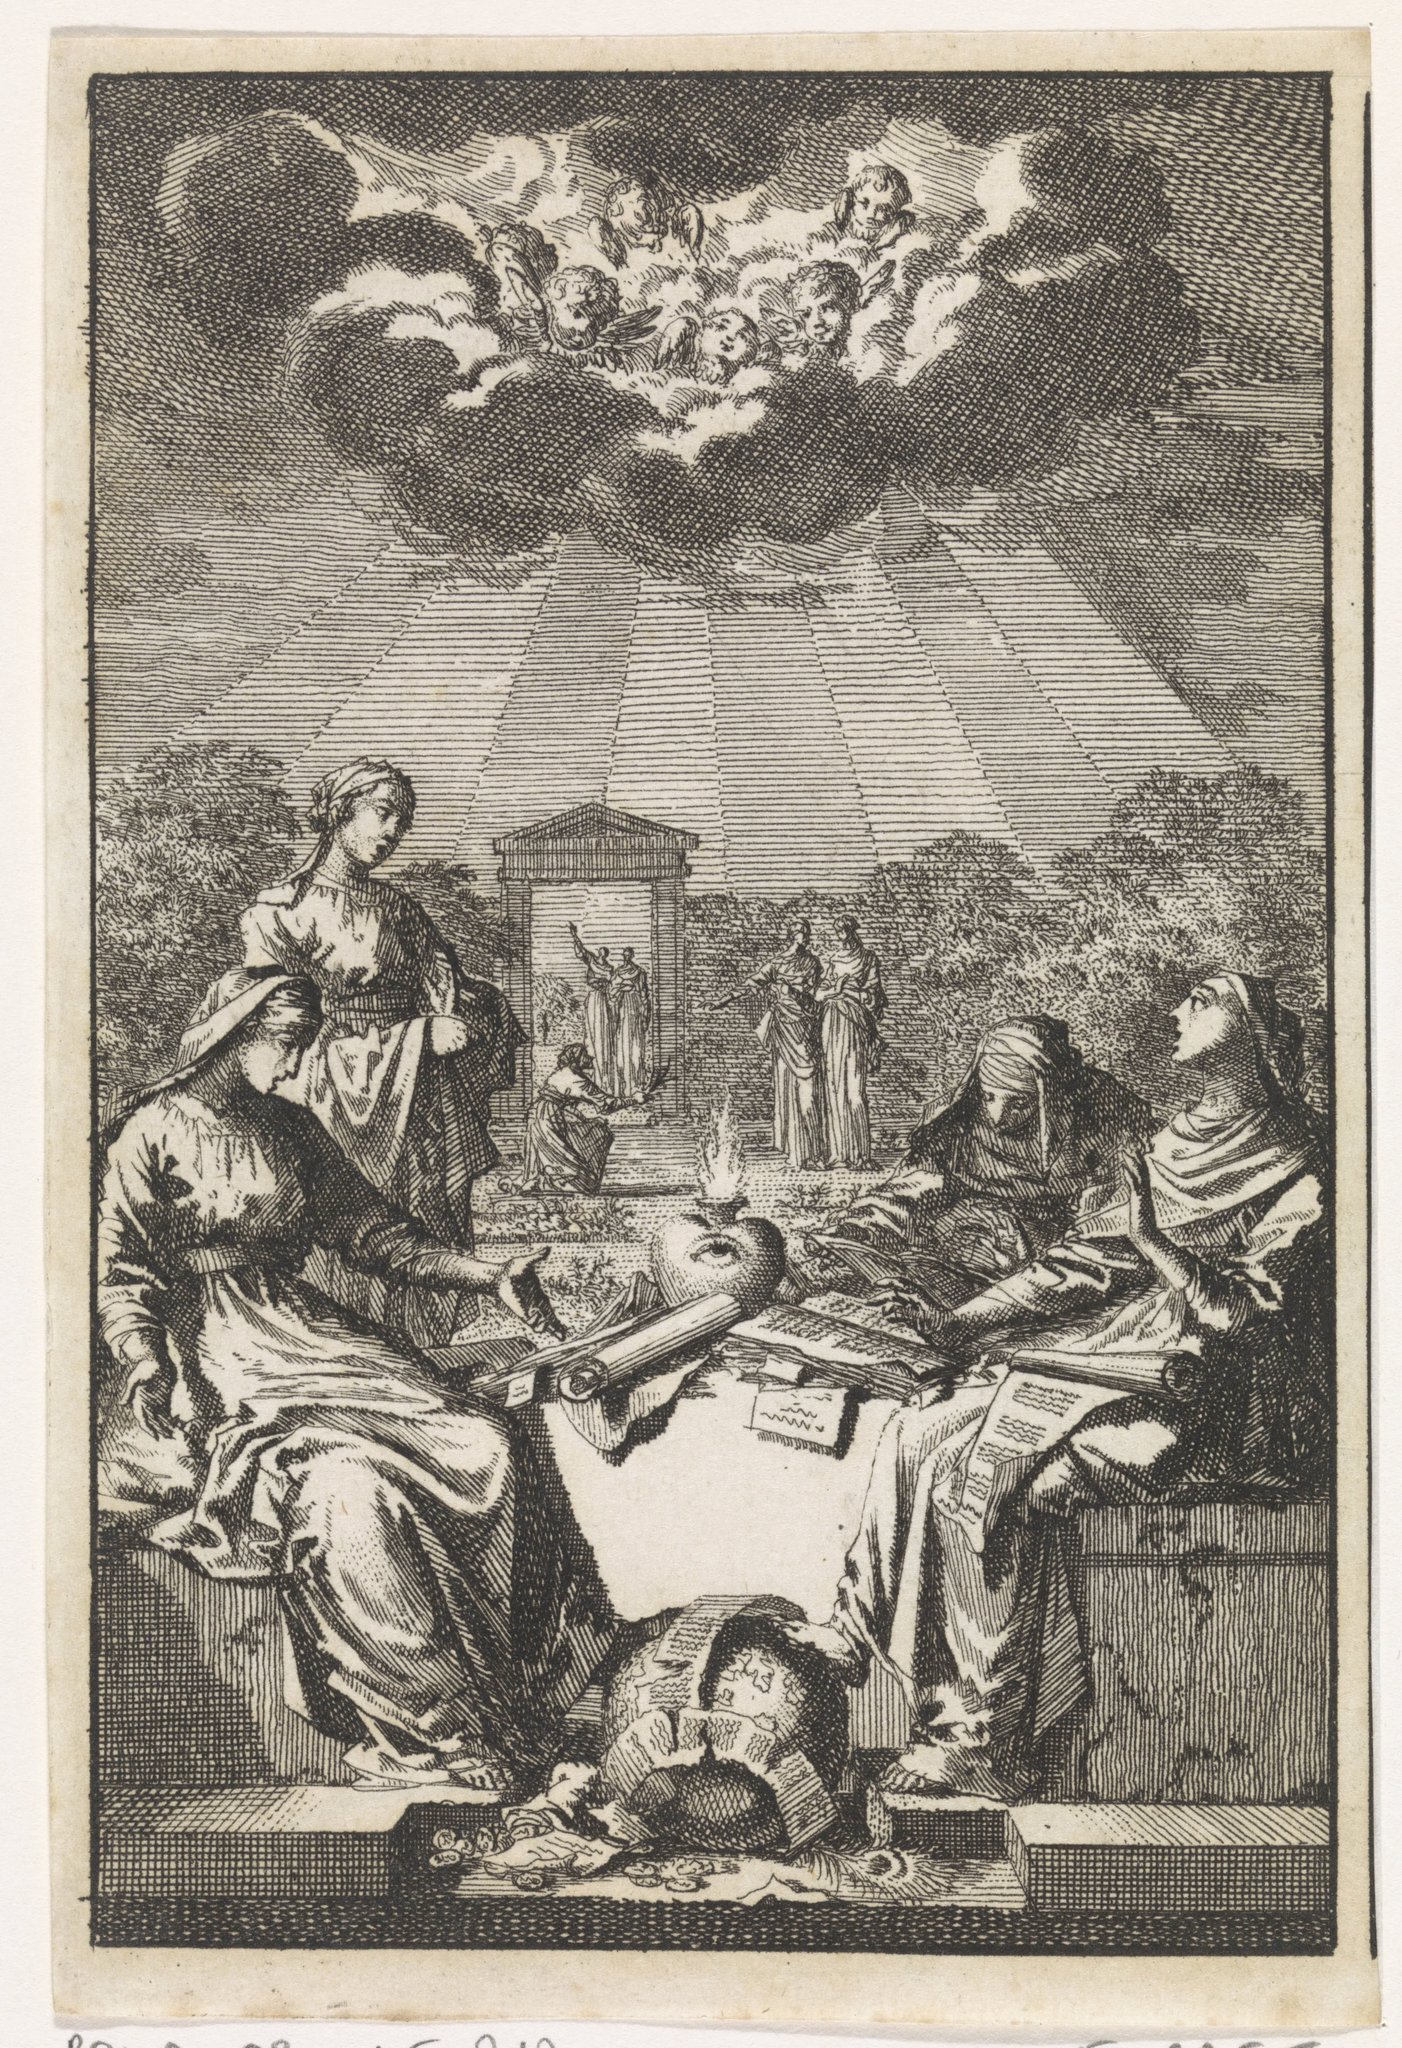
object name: print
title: Vrouwen aanschouwen een brandend hart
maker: jan luyken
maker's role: draughtsman, print maker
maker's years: 1649-1712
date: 1704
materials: paper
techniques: etching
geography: amsterdam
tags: cherubs, i.e. children's heads with wings, garden, the sacred heart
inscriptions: collector's mark: Lugt 2228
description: In een tuin aanschouwen vier vrouwen een brandend hart, symbool van goddelijke liefde. De twee vrouwen op de voorgrond vertreden samen een wereldbol. Vanuit een wolk in de lucht kijkt een groep cherubijnen toe.